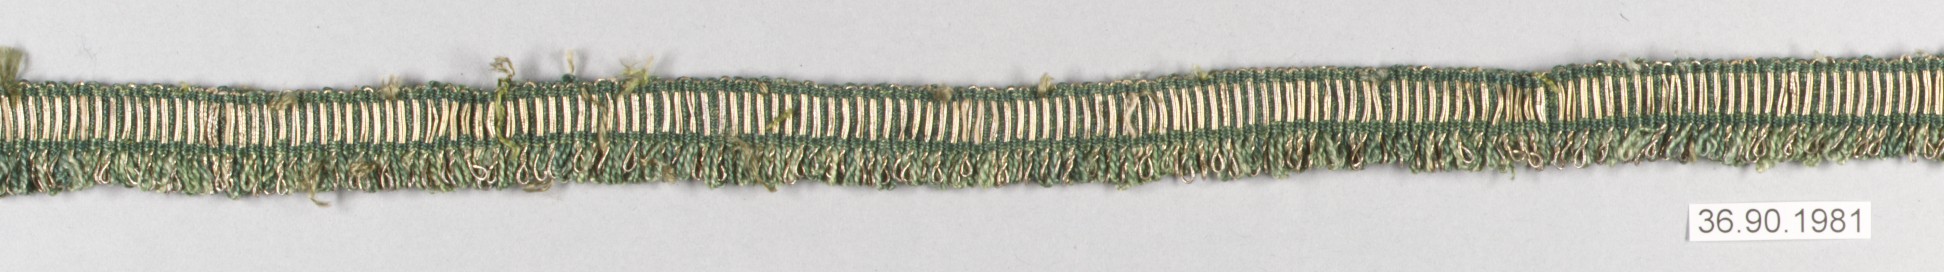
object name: fringe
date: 1750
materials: metal thread, silk